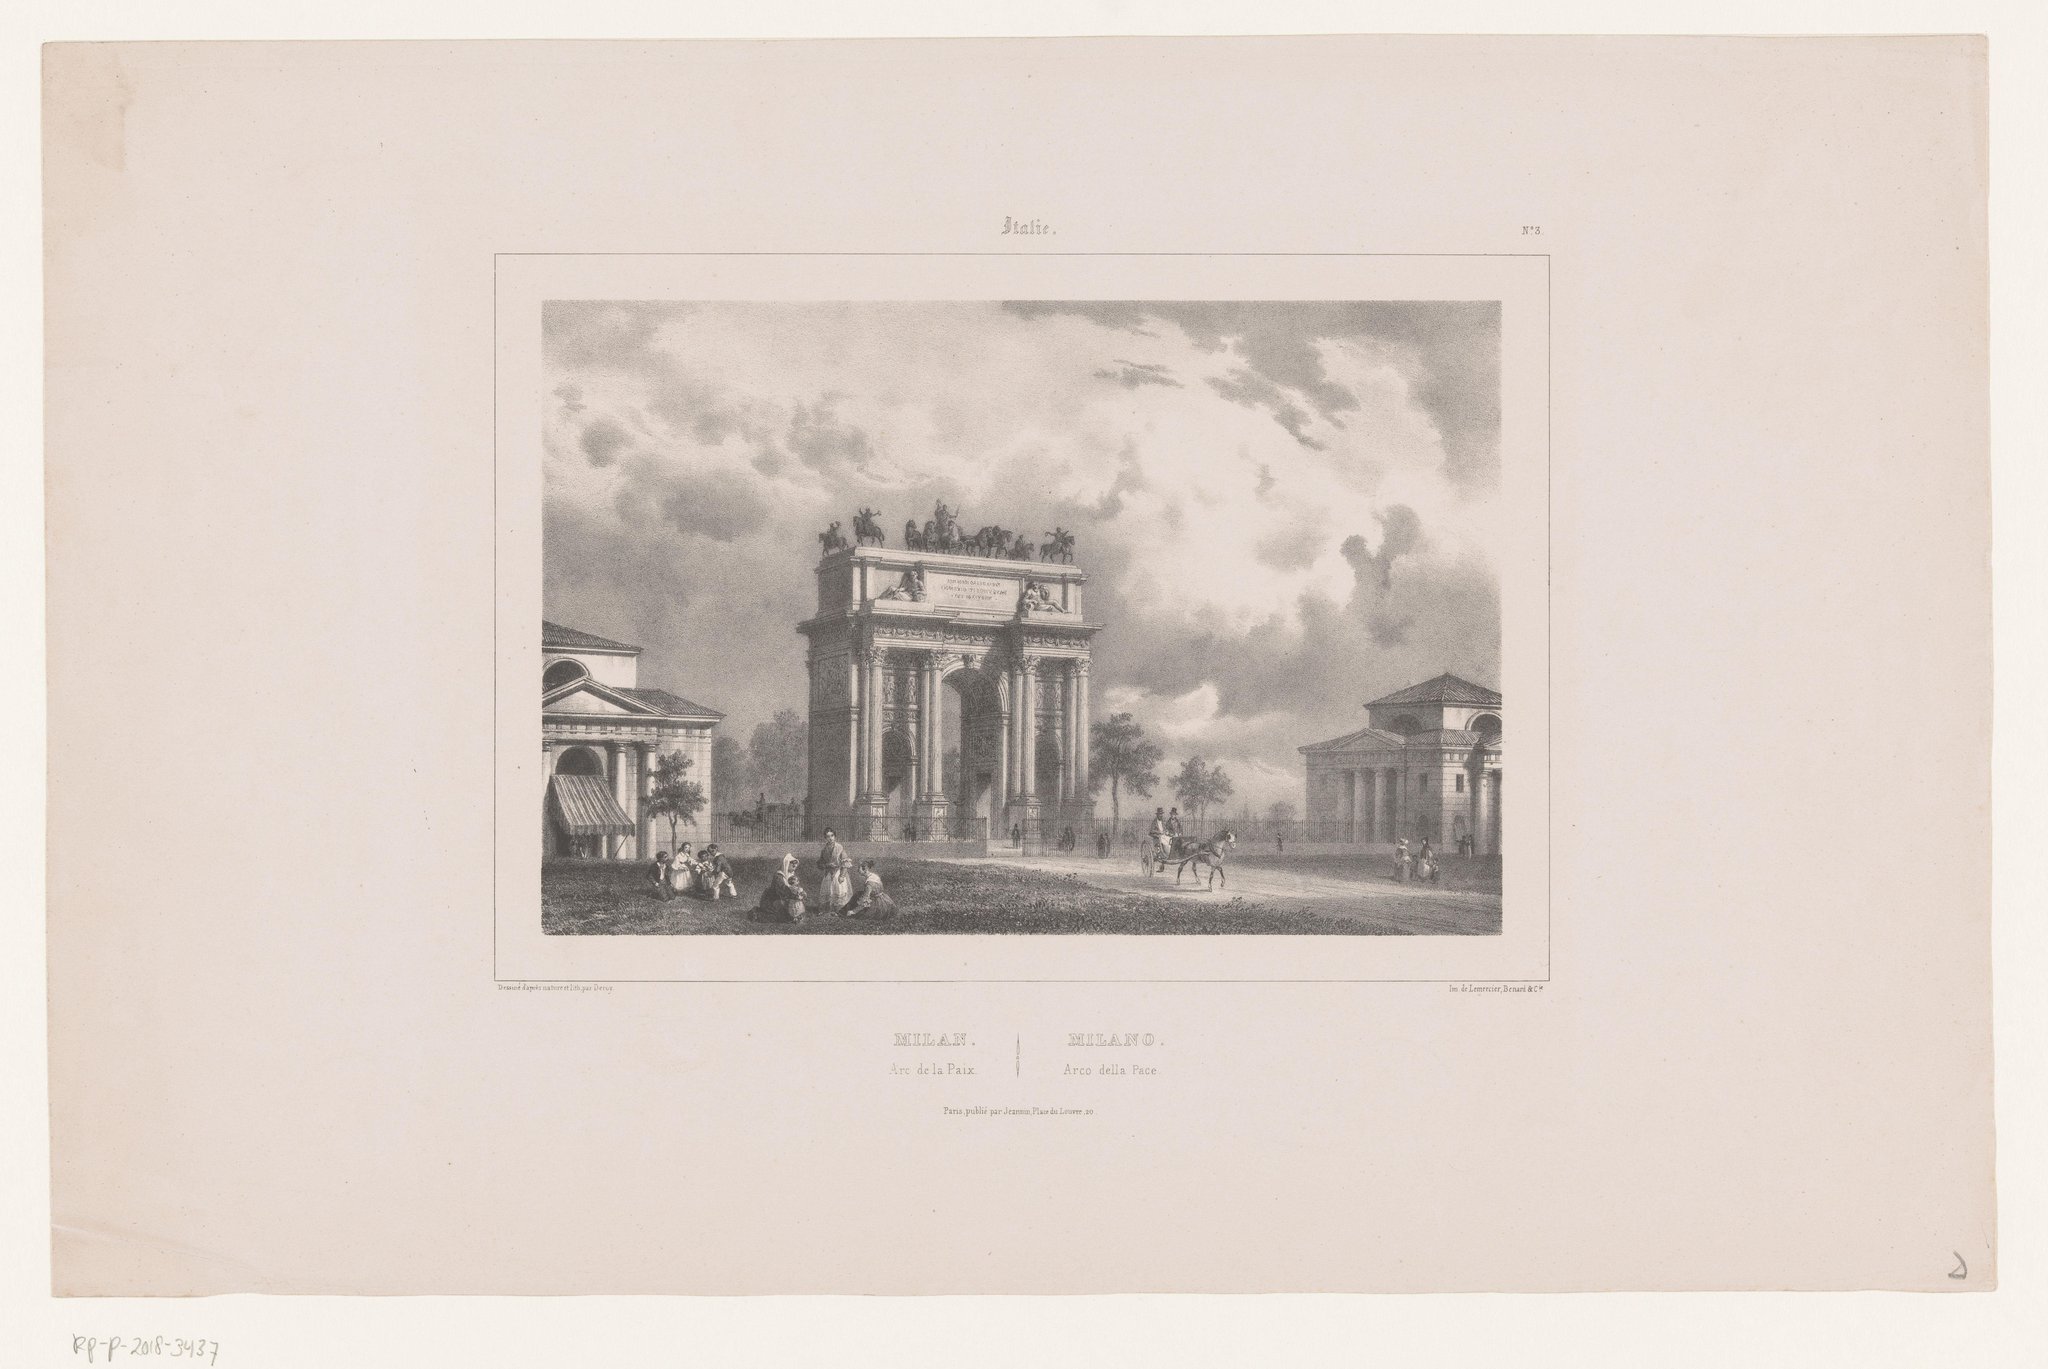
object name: print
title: Gezicht op de Arco della Pace in Milaan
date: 1838-1841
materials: paper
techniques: lithograph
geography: paris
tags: triumphal arch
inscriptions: check stamp: Lugt 1397c, collector's mark: Lugt 2228